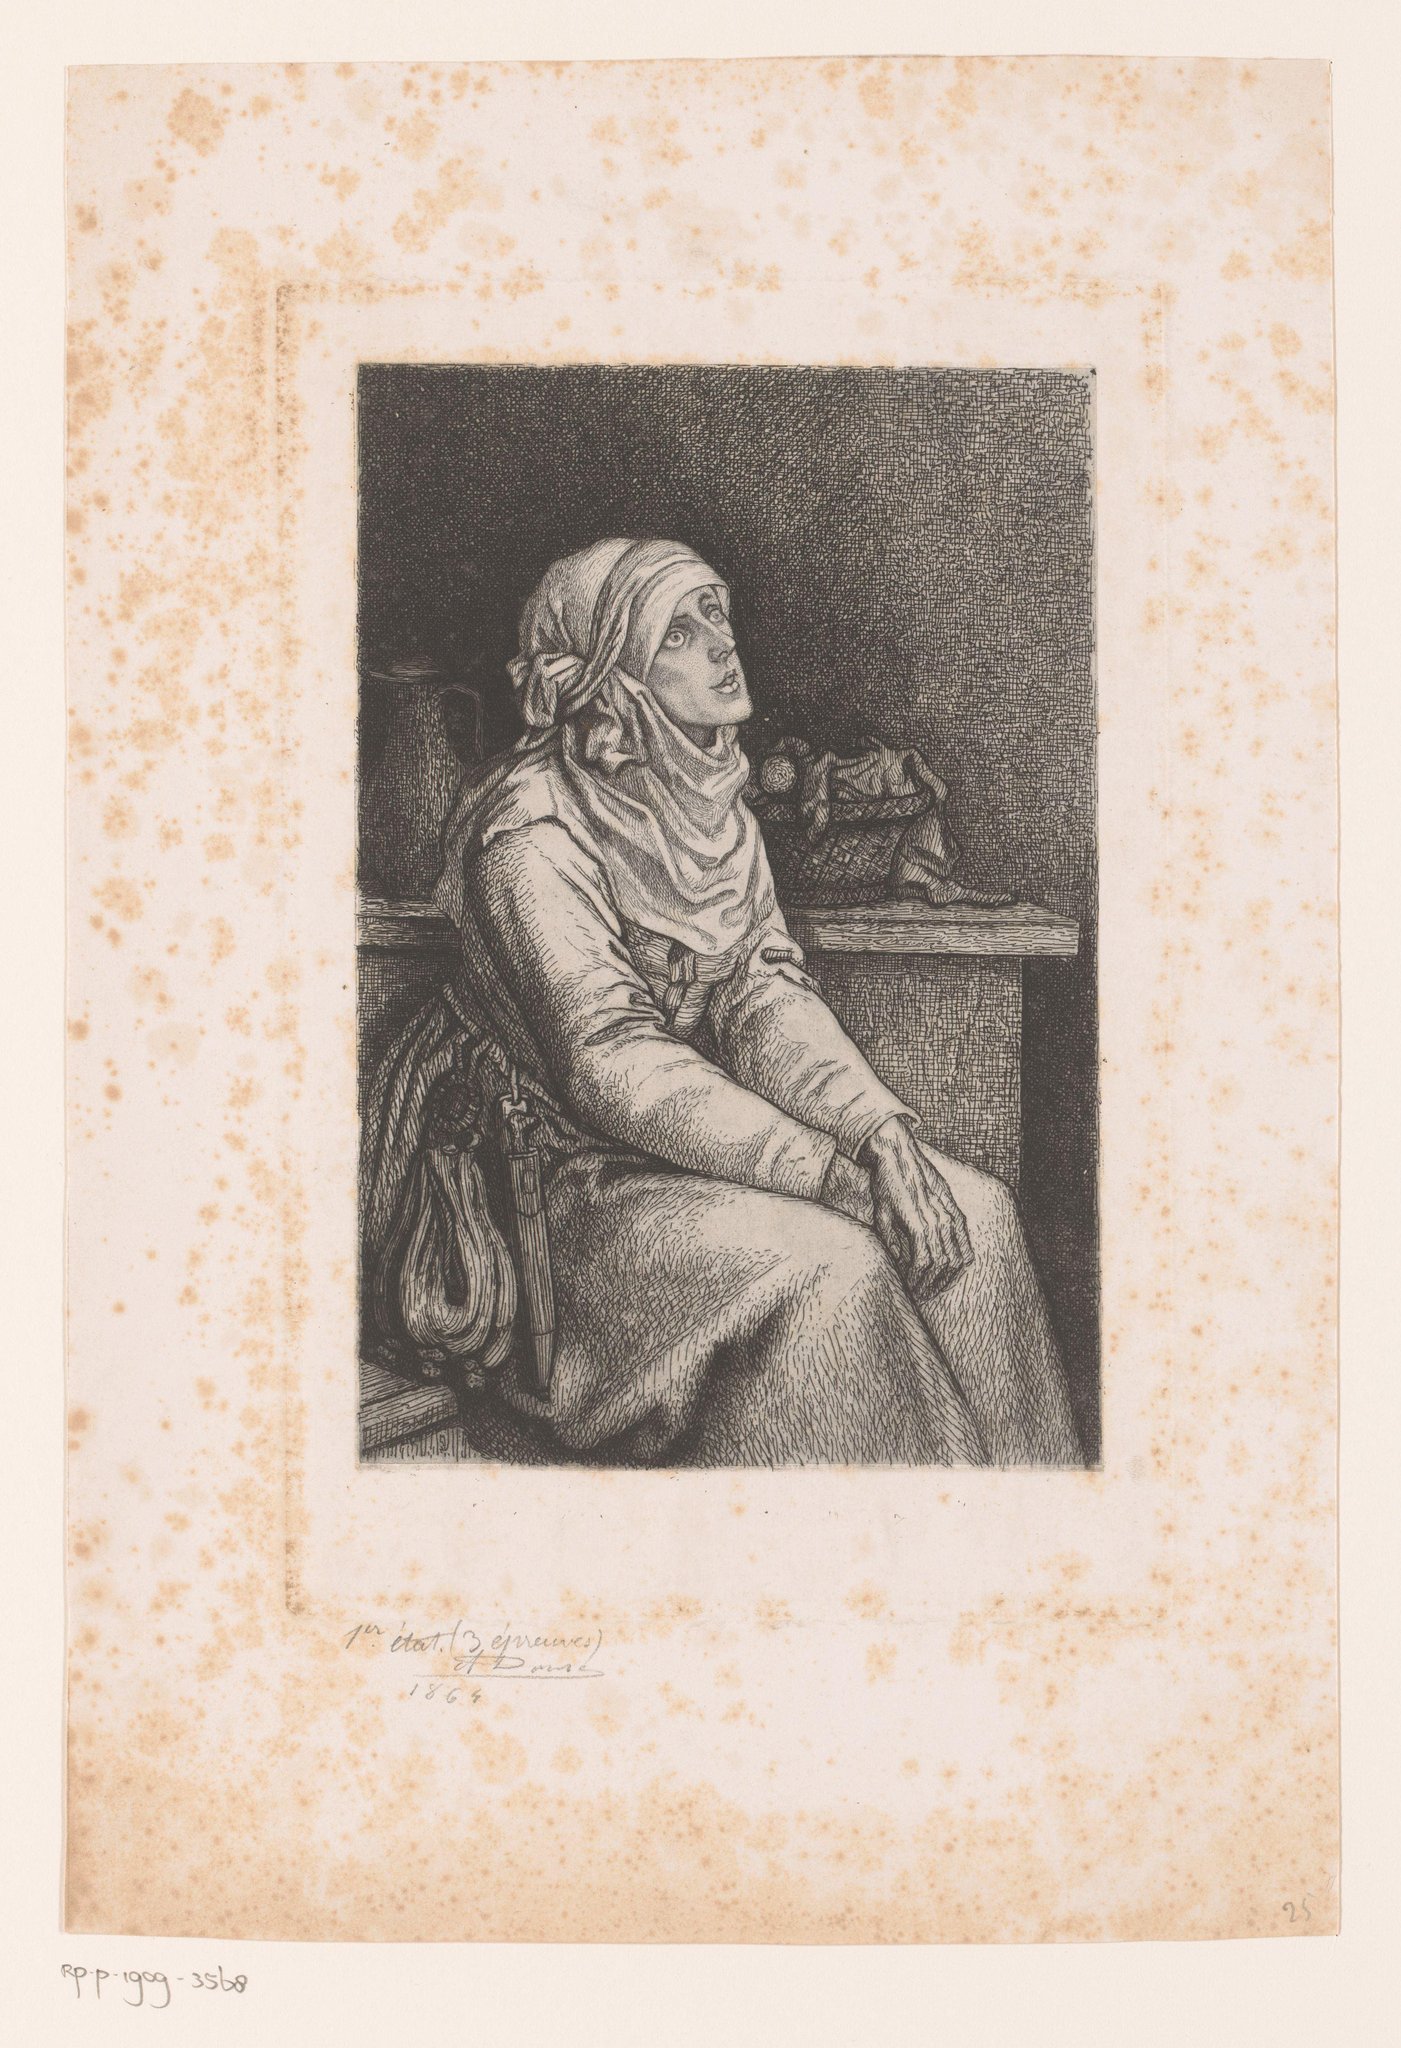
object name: print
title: Katheline la folle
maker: auguste danse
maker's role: print maker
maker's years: 1829-1929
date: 1864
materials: paper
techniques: drypoint, etching, intaglio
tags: adult woman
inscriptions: collector's mark: Lugt 2228, annotation: ‘1er état (3 épreuves)’